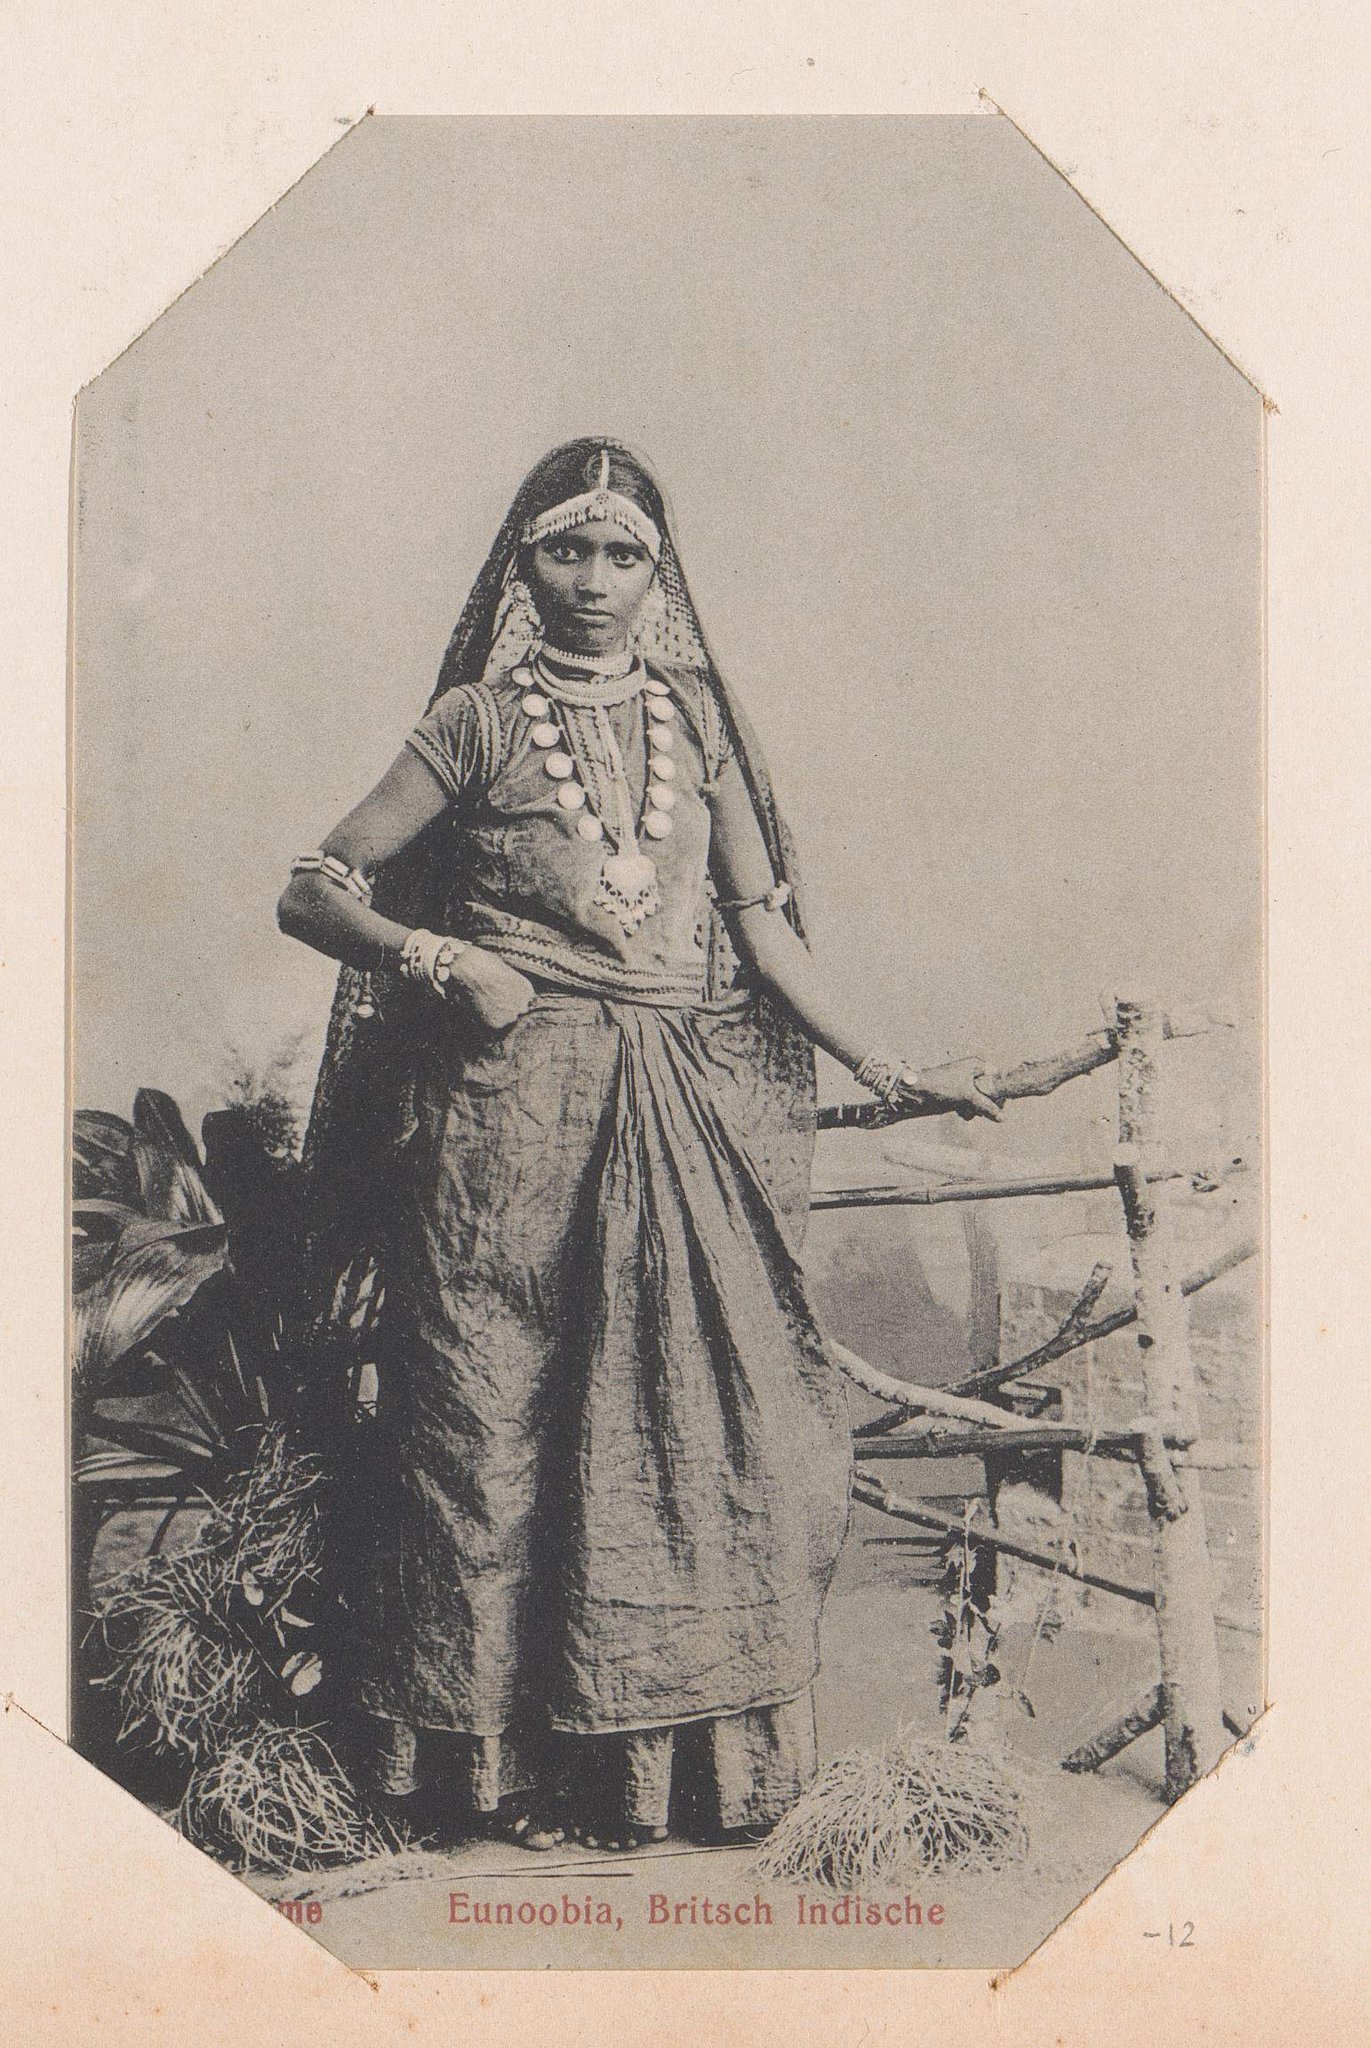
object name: ansichtkaart, prentbriefkaart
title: Postcards with Photographs of Hindustani Women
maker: eugen klein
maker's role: fotograaf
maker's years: 1869-1927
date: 1900-1910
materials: cardboard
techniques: photograph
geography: suriname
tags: standing figure - aa - female human figure, suriname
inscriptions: serial number: ‘Eigendom van Eugen Klein, Paramaribo No. 178’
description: A seductive picture of Hindustani women – beautifully dressed and wearing jewellery unknown to many Europeans, such as the chucchi (nose ring) – was sent as a postcard to the Netherlands. It serves as an advertisement for the colony, an encouragement to come to Suriname. The poses of the women on the cards have a certain eroticism. The addition of their names further piques the imagination.